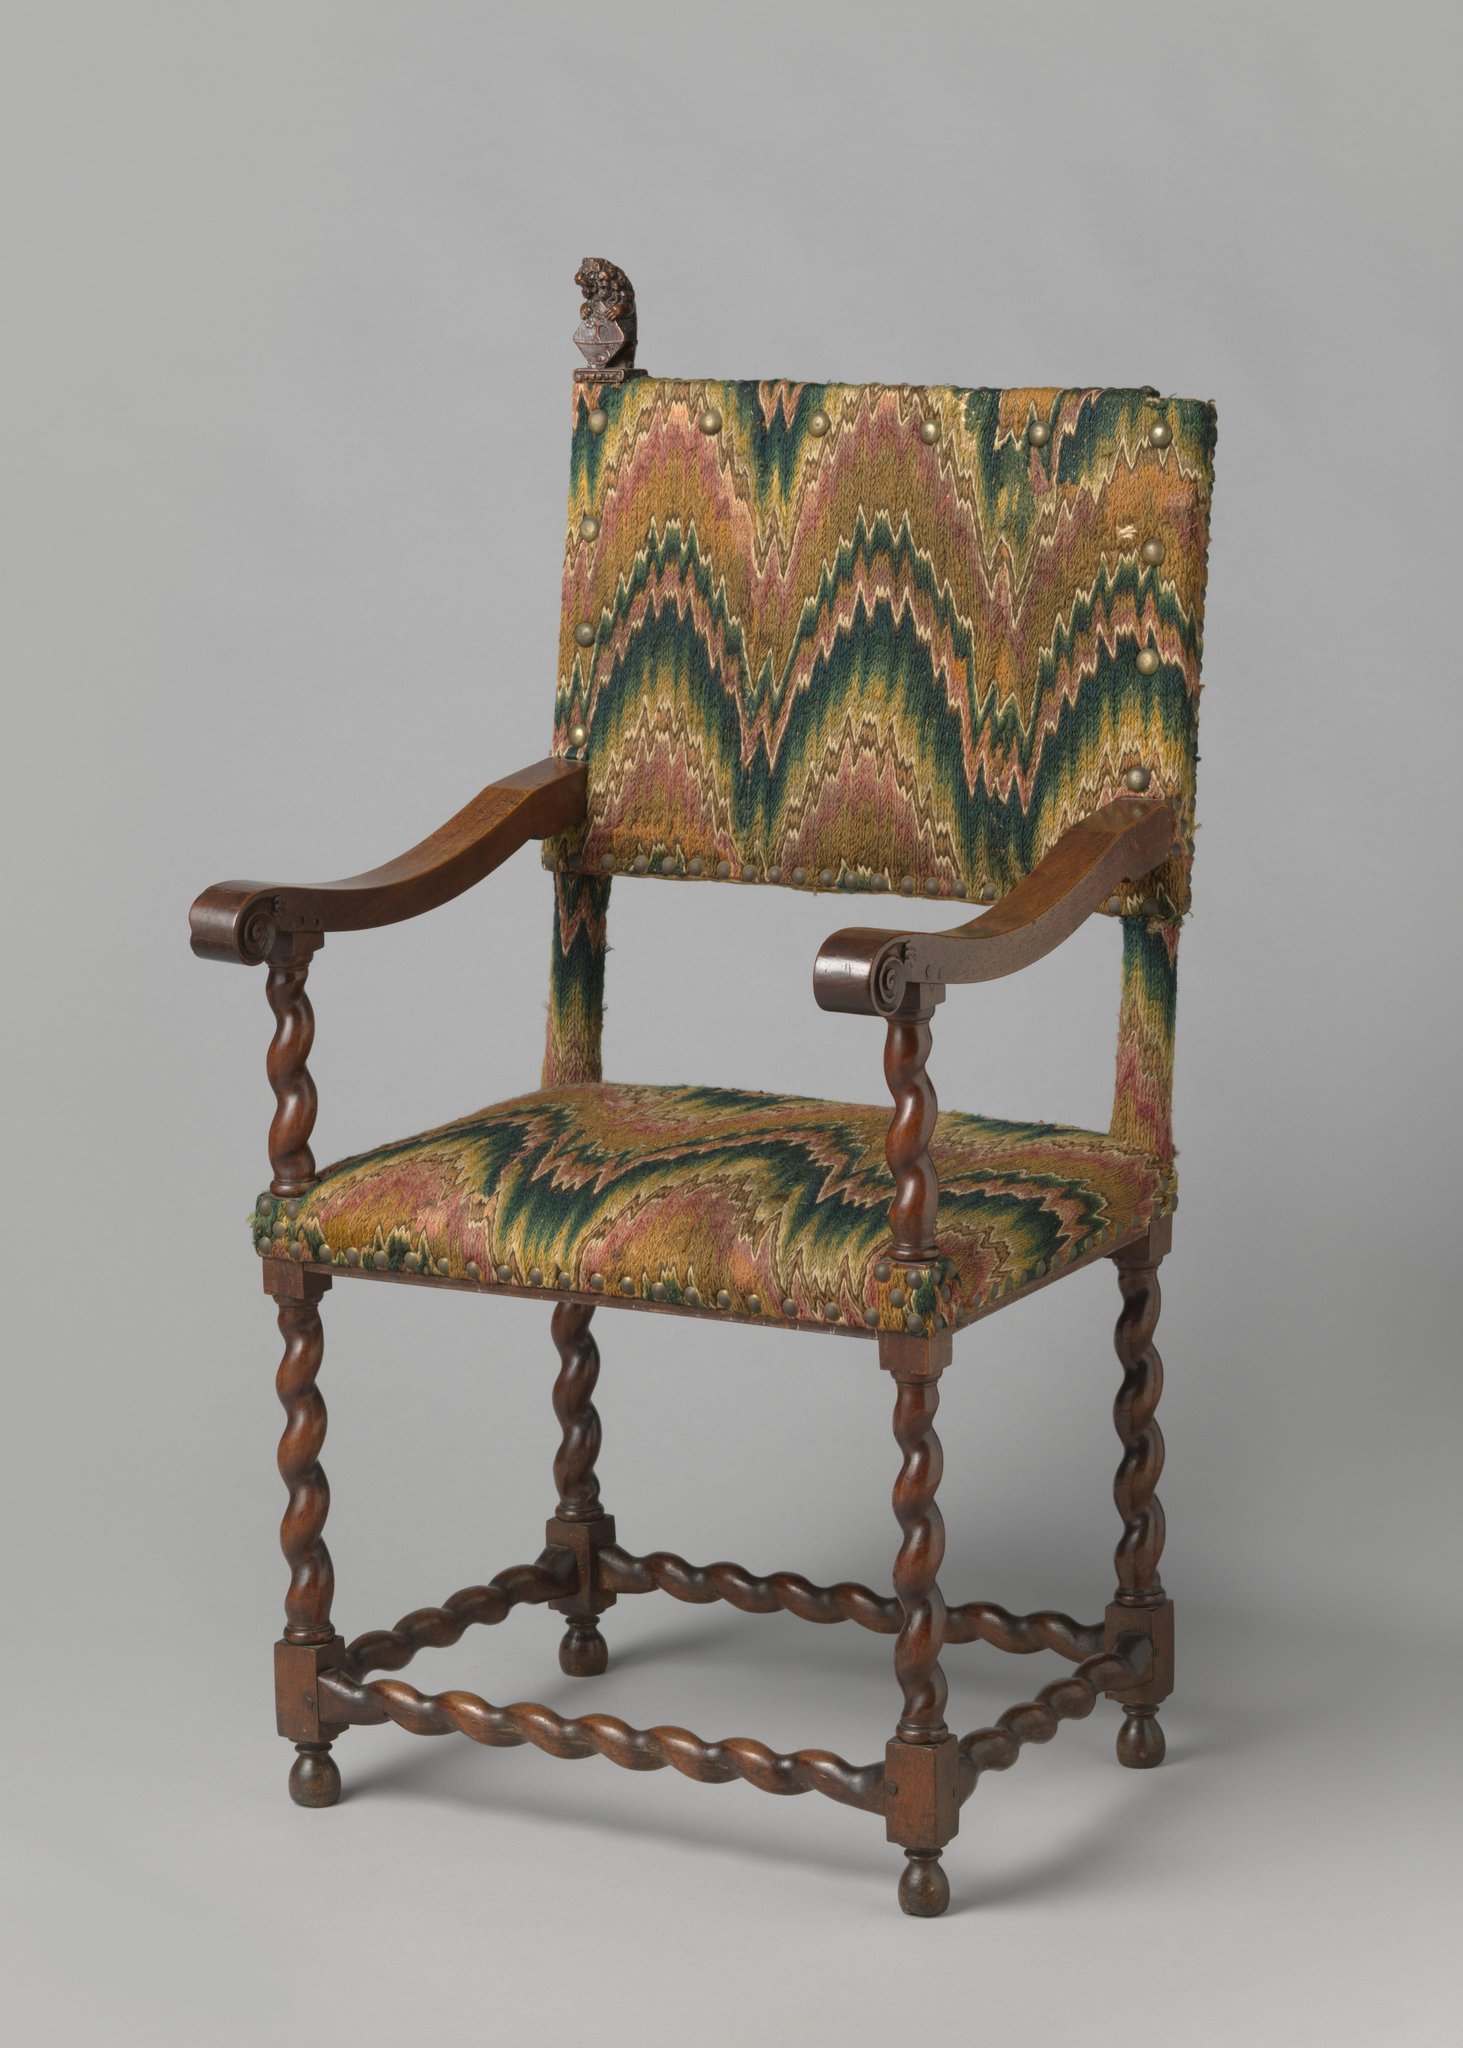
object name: chair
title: Meubilair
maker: Anonymous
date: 1640-1660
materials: wood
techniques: embroidery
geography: northern netherlands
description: Armstoel van notenhout, bekleed met point d'Hongrie in verschillende kleuren. Het meubel heeft geslingerde poten, door plat geslingerde ondersporten verbonden. De geslingerde armleggerstutten dragen de armleggers, die licht gehold zijn en in voluten met spiralen op de zijkanten eidigen. De achterstijlen zijn bekroond door twee afzonderlijk gestoken leeuwen, die ieder een ruitvormig schild dragen (doorsneden, boven een boom, onder een naar links gewende zwaan) dragen.